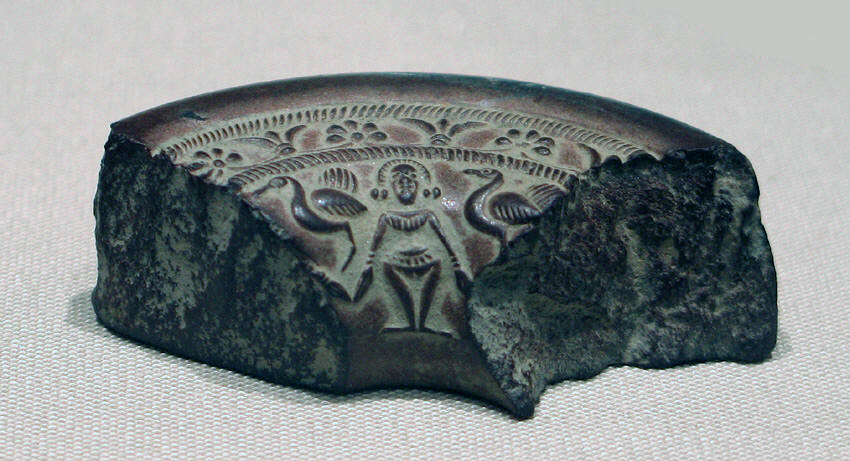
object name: ringstone fragment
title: Ring Stone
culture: indian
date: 101-100 BCE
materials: stone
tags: birds,maurya,mauryan,women